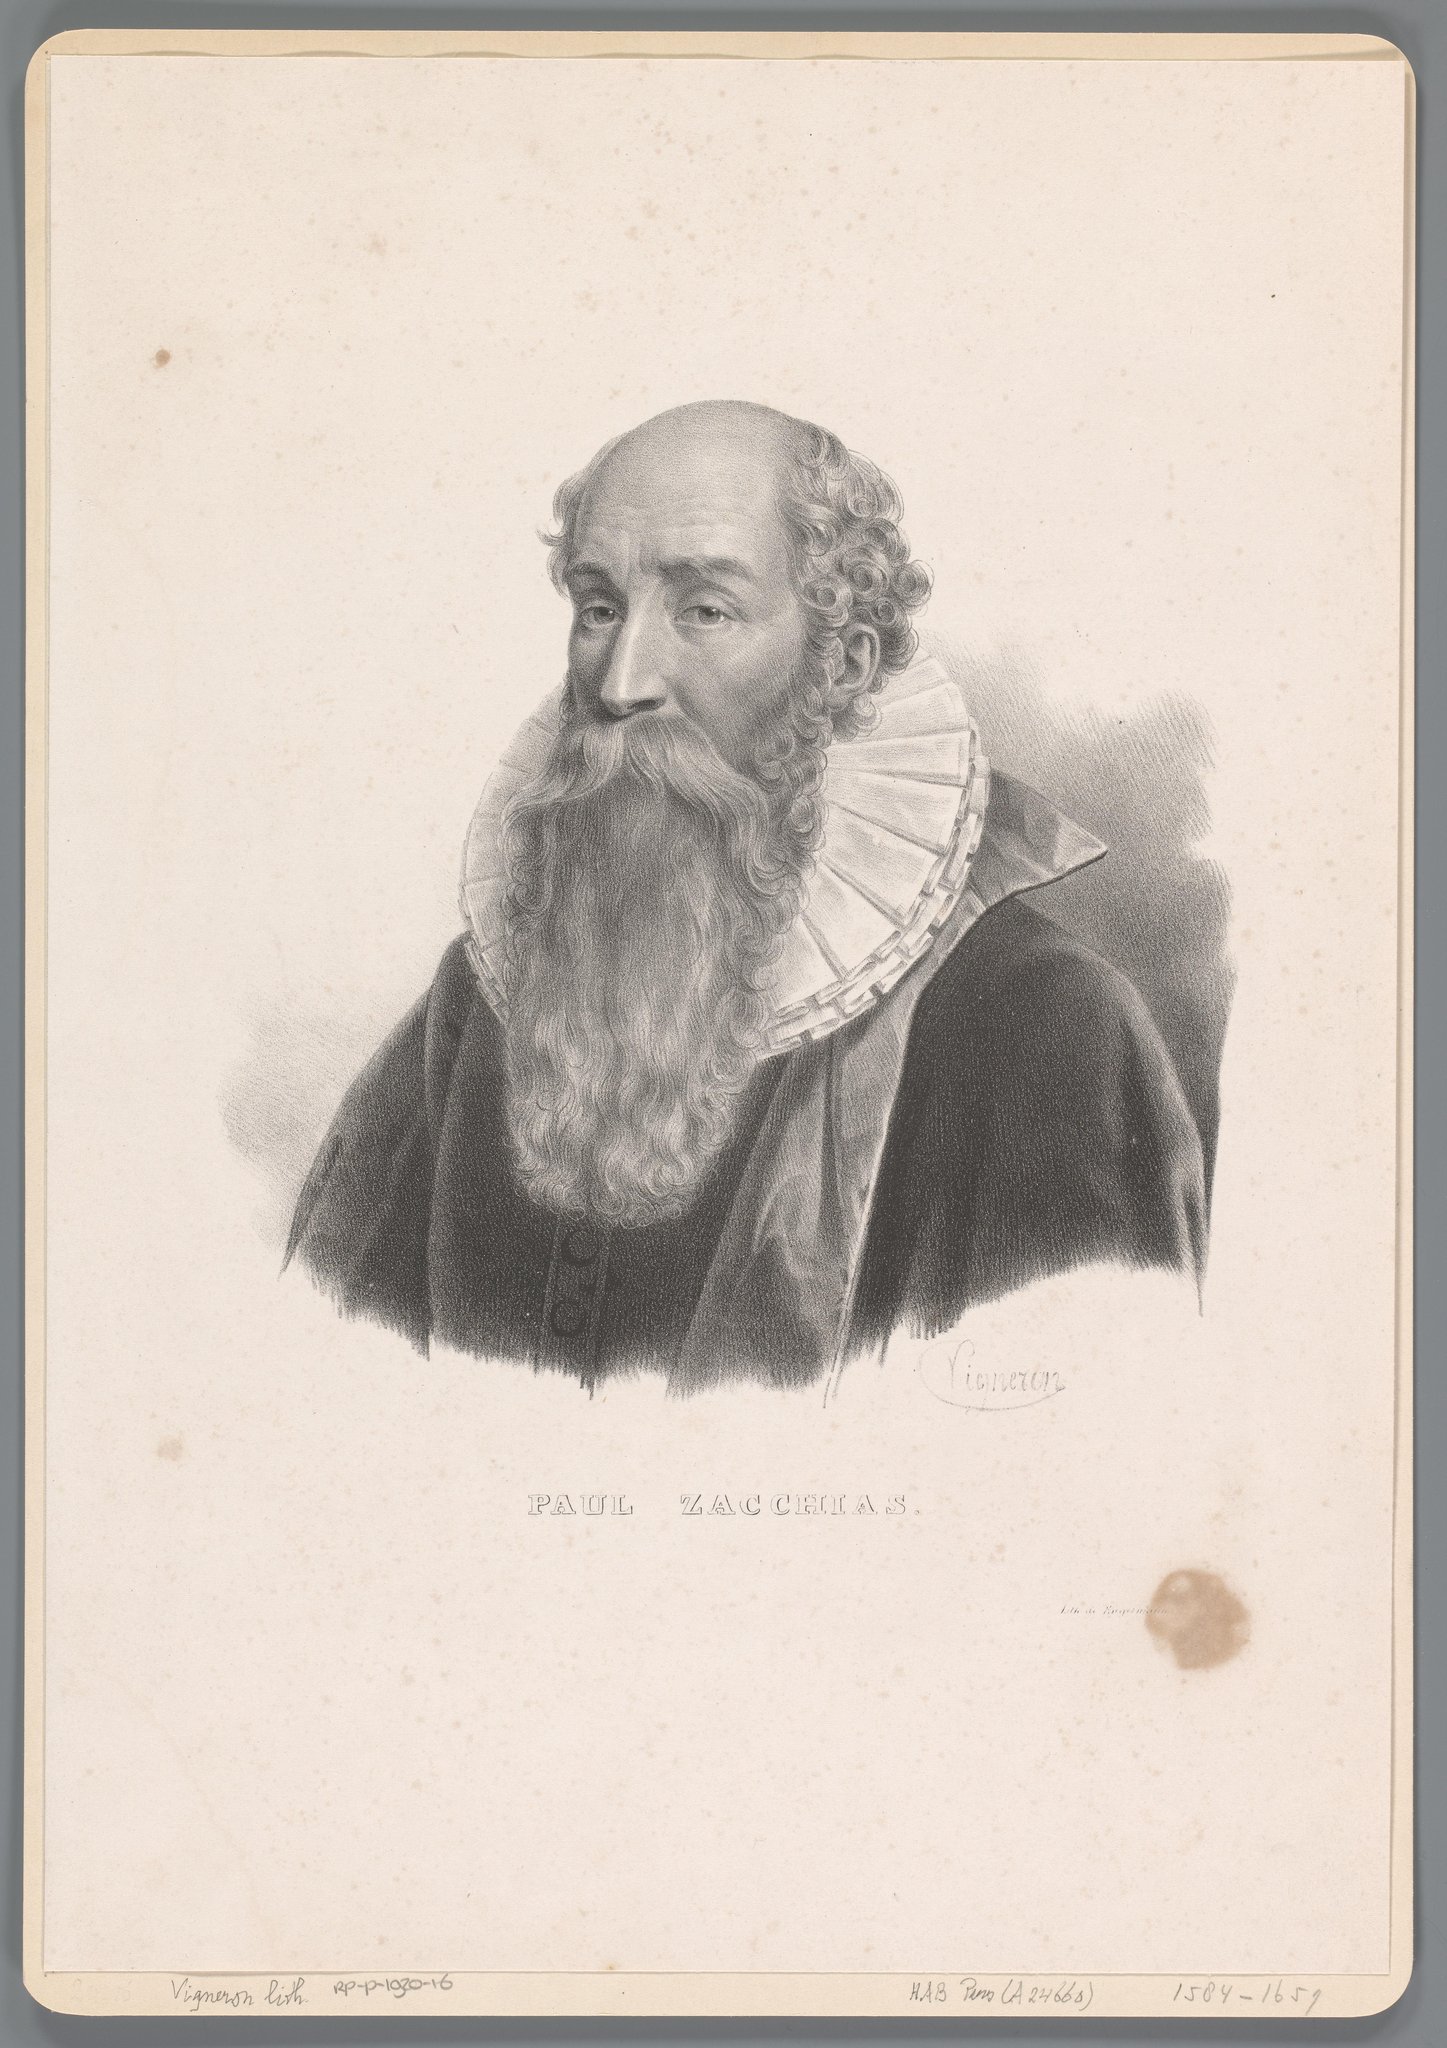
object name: print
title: Portret van Paolo Zacchia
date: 1816-1833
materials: paper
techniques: lithograph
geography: france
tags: rome, historical persons, physician, doctor (+ portrait of scholar, scientist)